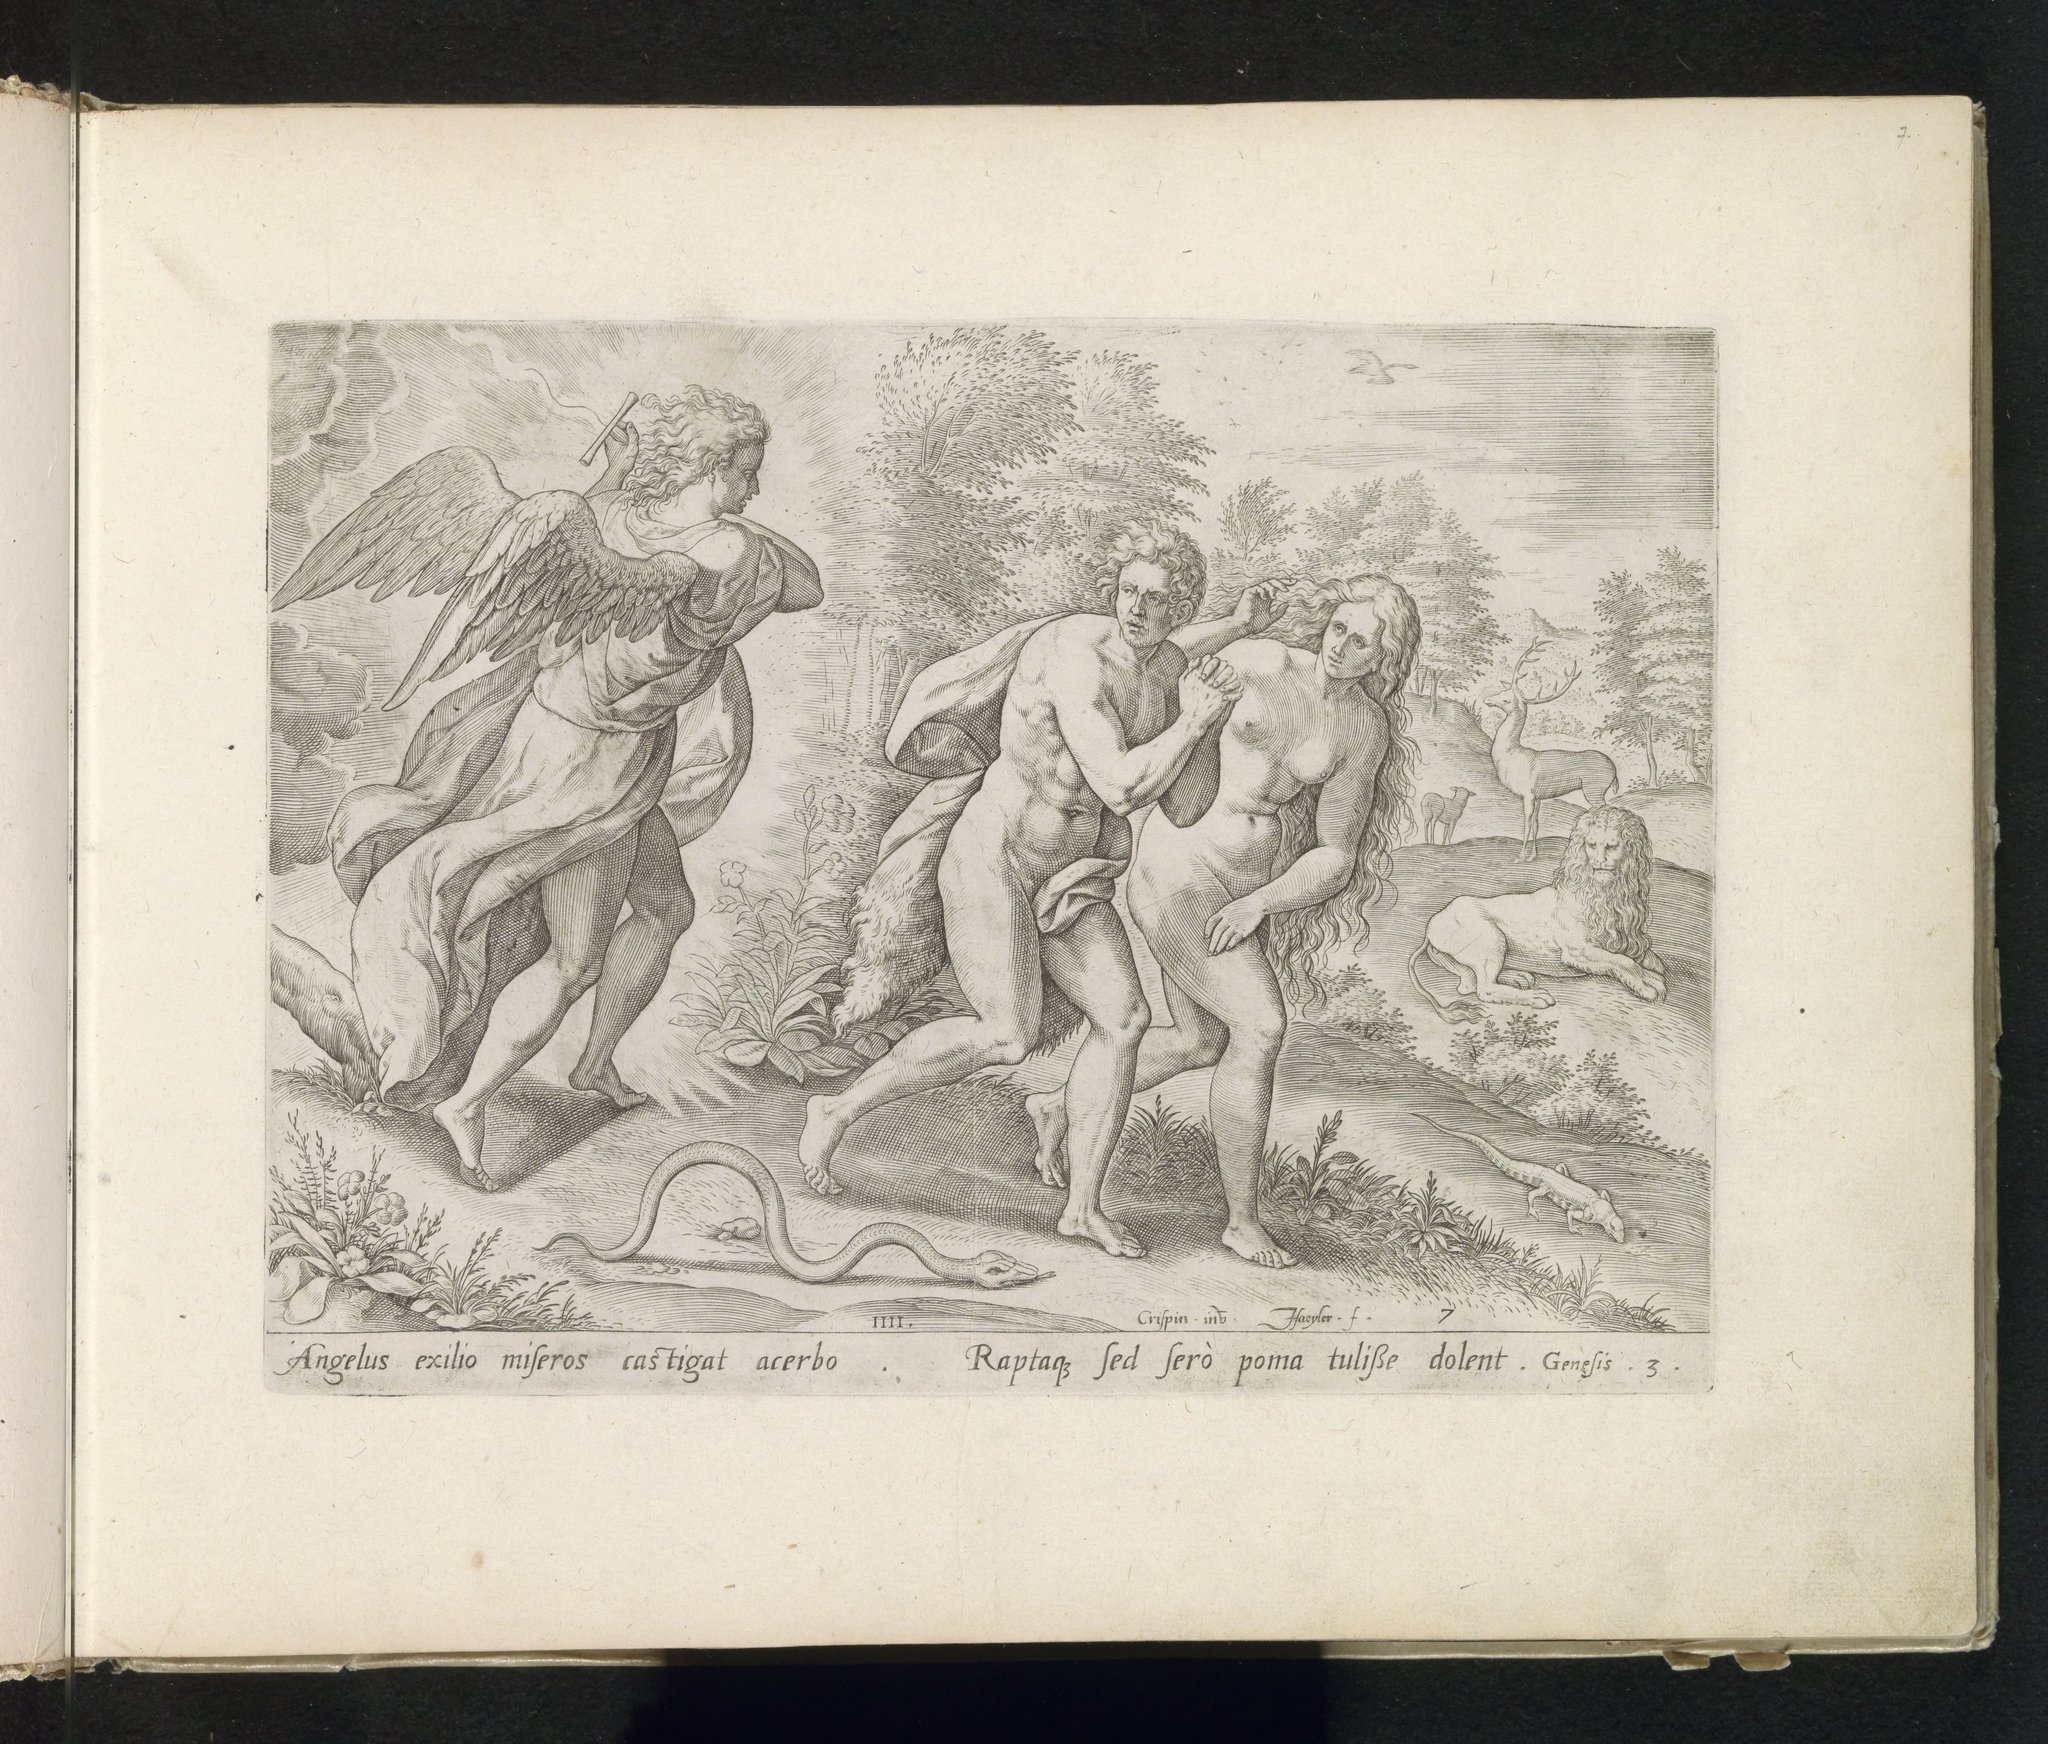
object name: album leaf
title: Expulsion from Paradise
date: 1585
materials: paper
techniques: engraving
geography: antwerp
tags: snakes, an angel chases adam and eve out of paradise with a (flaming) sword, beasts of prey, predatory animals: lion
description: Adam en Eva worden door een engel met een vlammend zwaard uit het paradijs verdreven. Naast hen kruipt de slang. Rechts op de achtergrond een leeuw en een hert. Onderaan een verwijzing naar de Bijbeltekst in het Latijn. Deze prent maakt deel uit van een album.